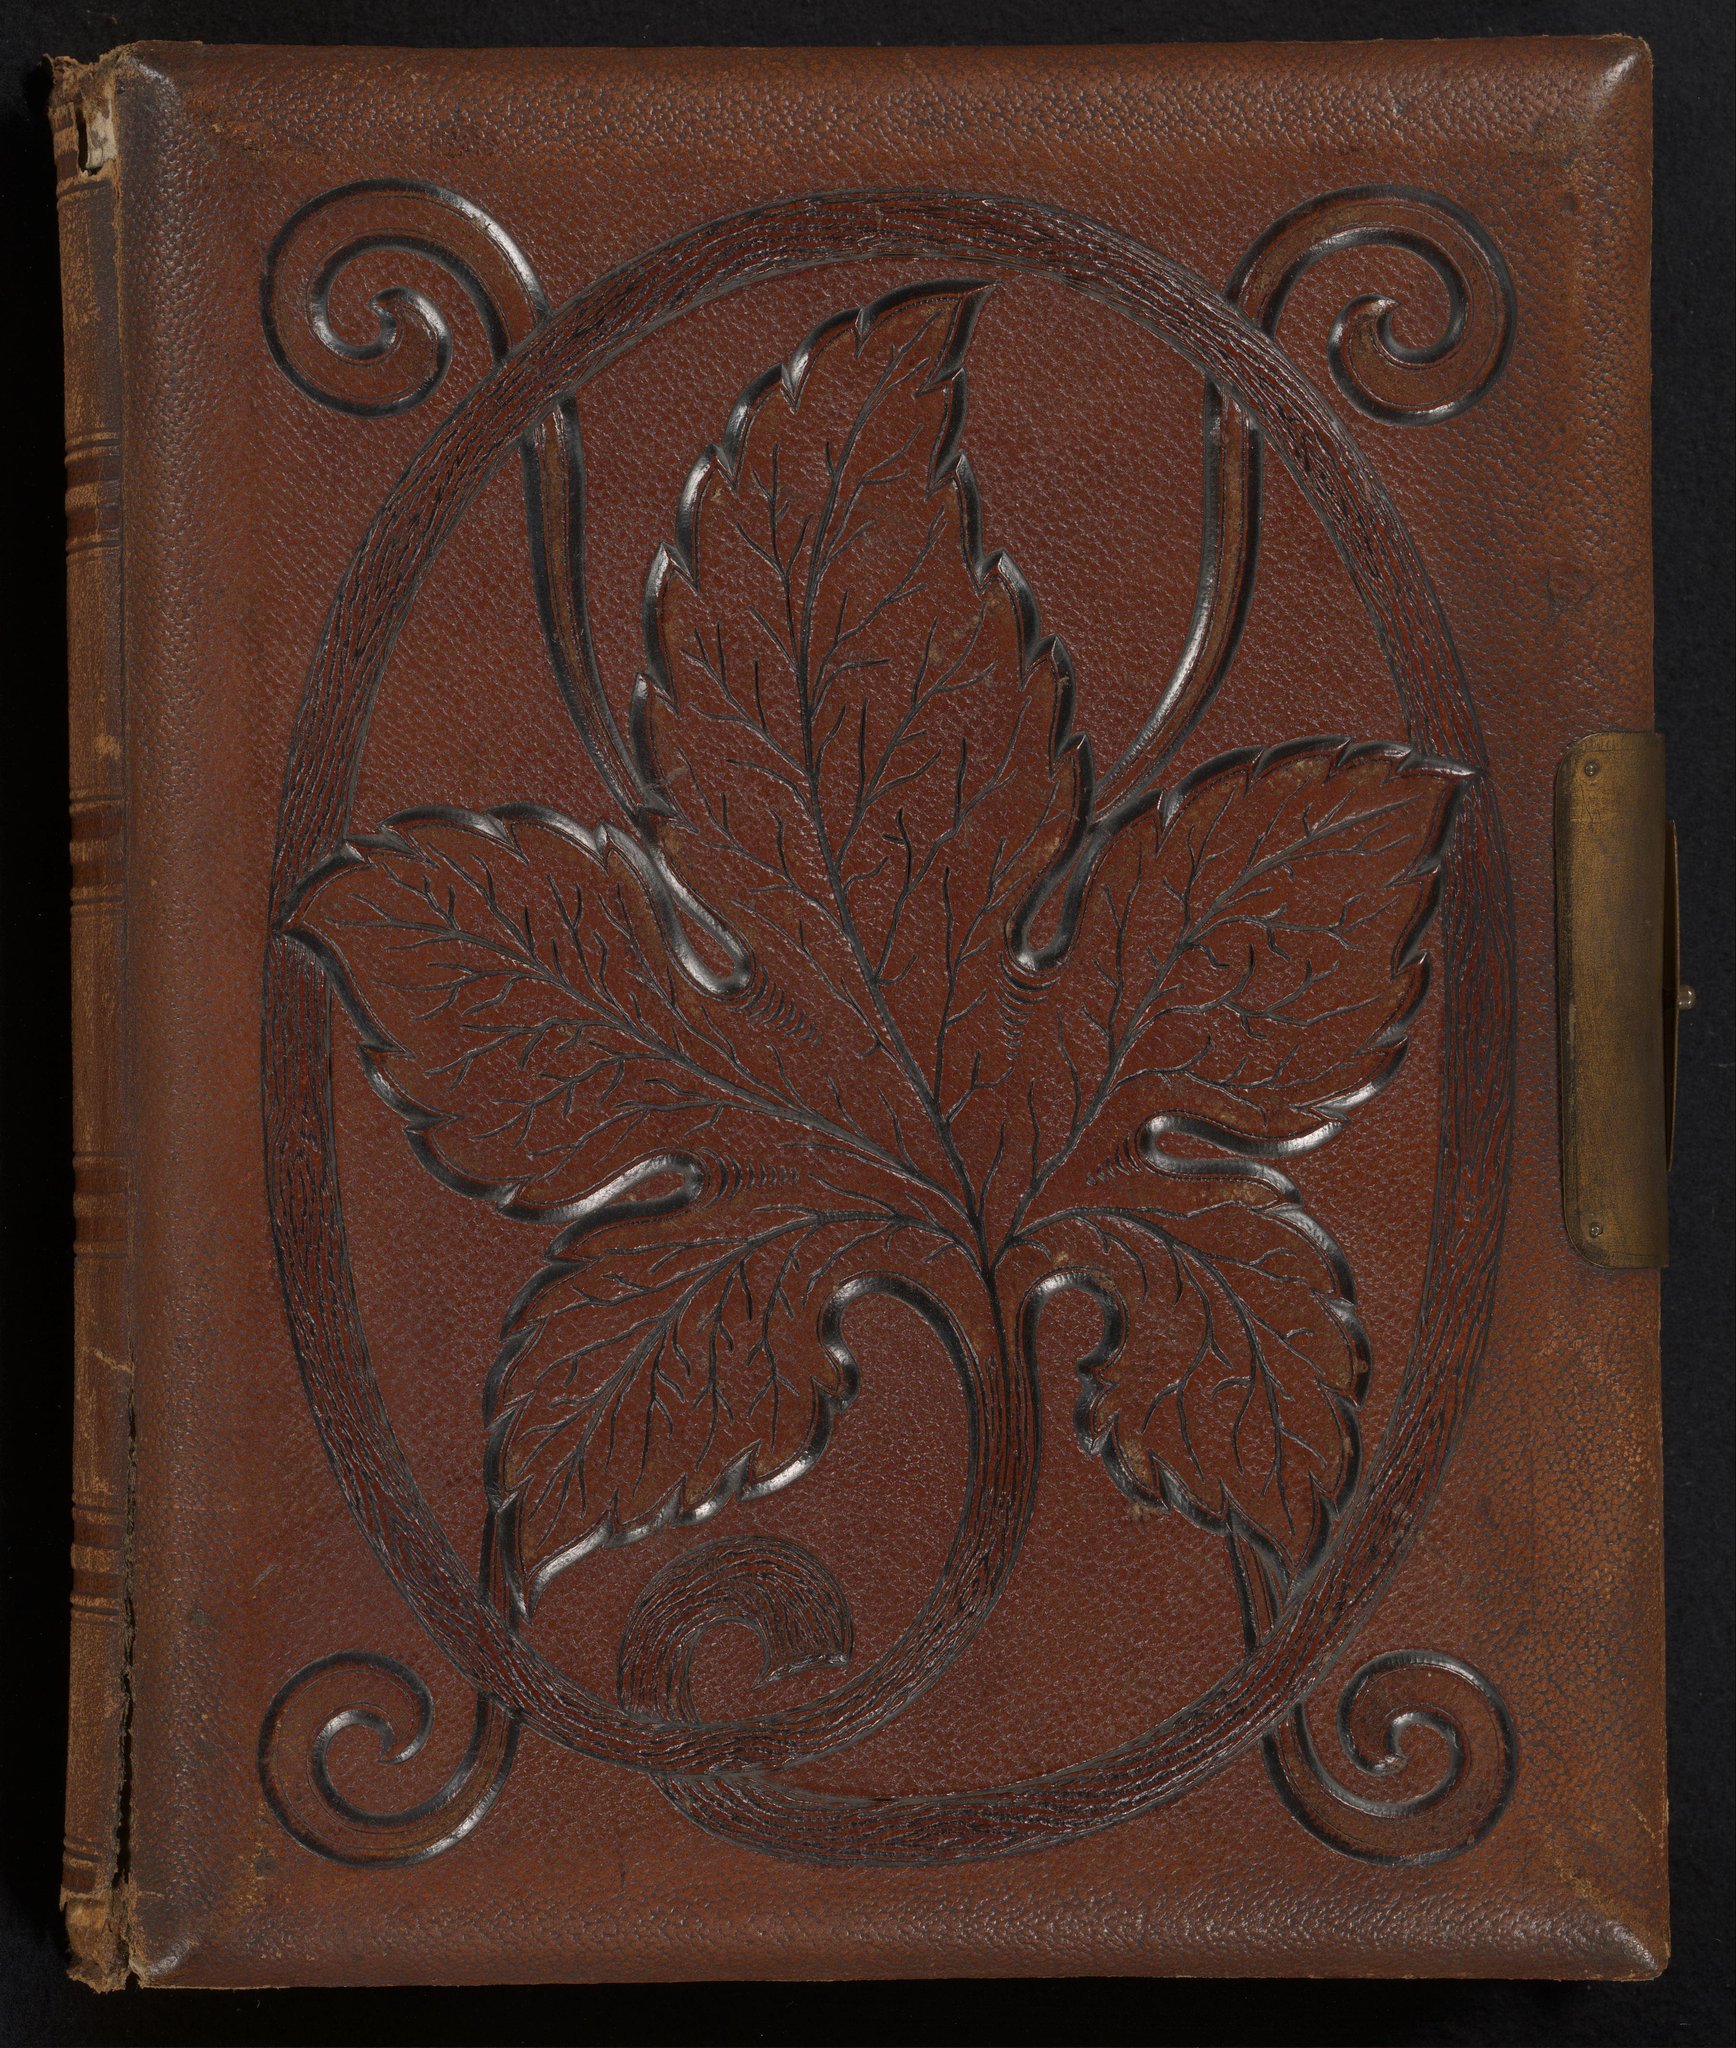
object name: photograph album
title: Fotoalbum van de Nederlandse familie Van Braam met 155 foto's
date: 1860-1900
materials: cardboard, copper, leather, paper, photographic support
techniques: albumen print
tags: marseille, politician, haarlem, historical persons - bb - woman, boy (child between toddler and youth), historical persons, girl (child between toddler and youth), head-gear: cap, anonymous historical persons portrayed in a group, in a group-portrait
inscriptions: collector's mark: ‘Dienst Verspreide Rijkskollekties (...) A 665’, number: ‘30.-’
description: Fotoalbum met 155 foto's op 23 bladen met insteekpasse-partouts op zowel carte-de-visite als kabinetkaart-formaat. Het zijn allemaal portretten vervaardigd door onder andere Hermanus Siderius, Albert Greiner, Hendrik Anthonie Karel Ringler, Wegner & Mottu en Eduard Fuchs. Het merendeel van de foto's is vervaardigd in Amsterdam en Leeuwarden en is samengesteld door familie Van Braam. Achterin zit 1 losse foto.